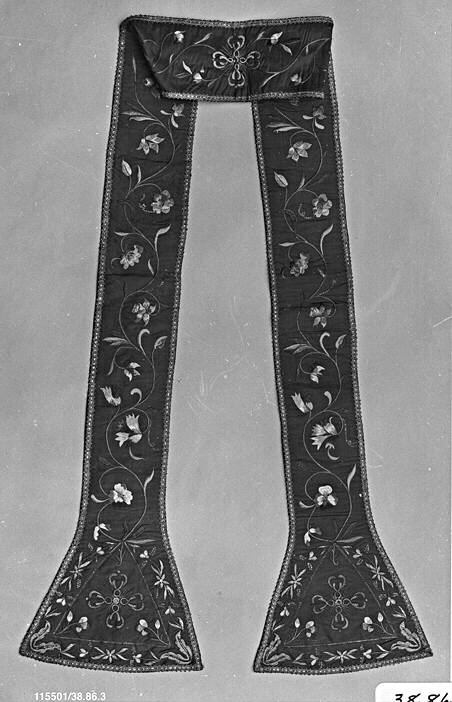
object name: stole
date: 1890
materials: metal thread, silk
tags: flowers